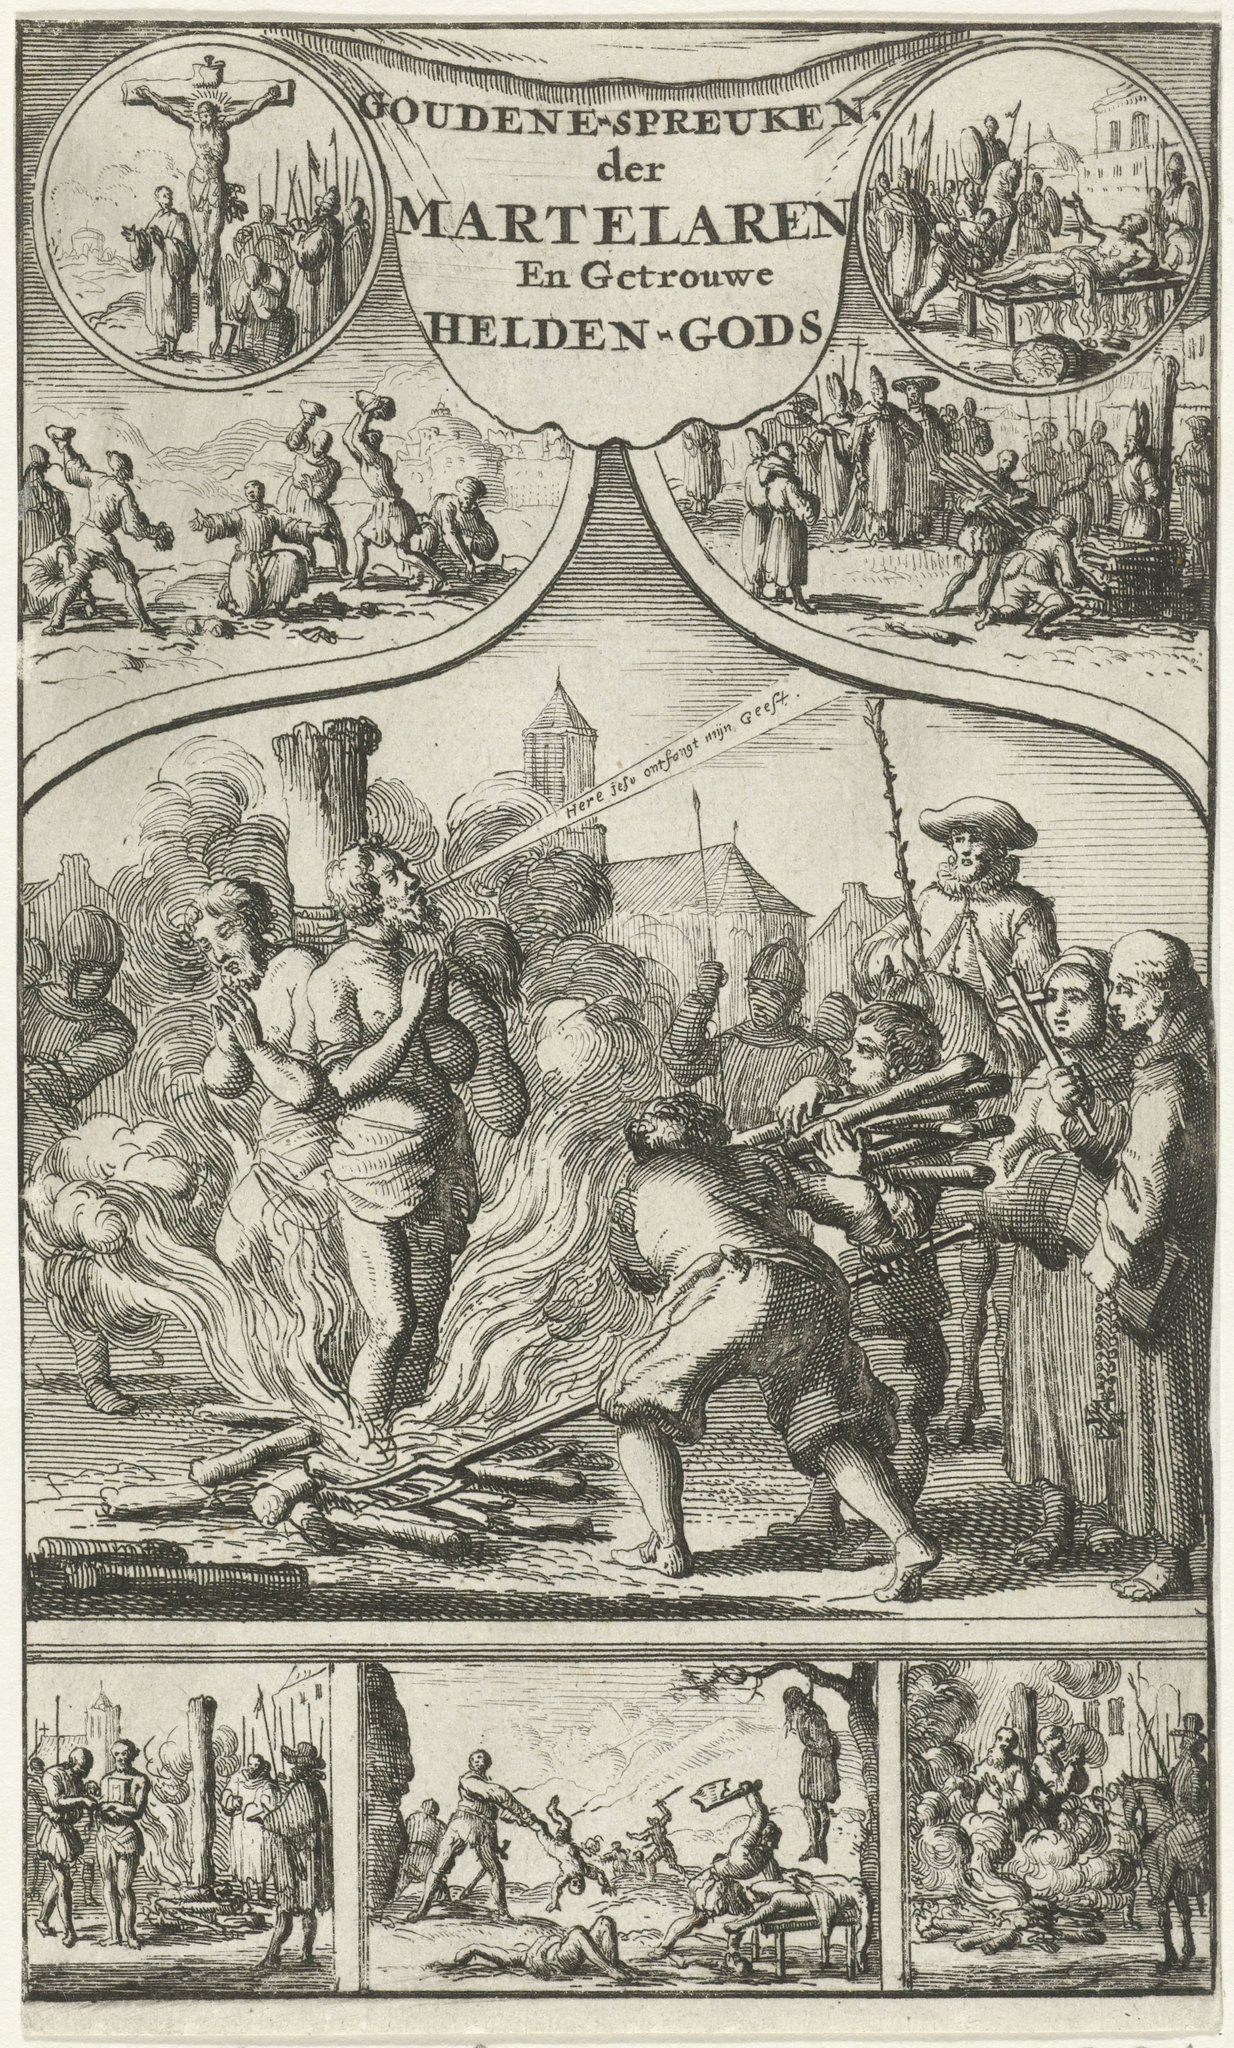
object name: print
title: Twee vastgebonden mannen worden levend verbrand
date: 1683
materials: paper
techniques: etching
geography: amsterdam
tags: christ crucified on a 'living' cross, martyrdom and death of stephen, st. laurence is roasted on a gridiron, violent death ~ fire, violent death, being killed; being mishandled and maltreated; seeking death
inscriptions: collector's mark: Lugt 2228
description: Twee vastgebonden mannen worden levend verbrand. Onder deze hoofdvoorstelling drie scènes waarin figuren op wrede wijze worden vermoord. Boven de hoofdvoorstelling zijn de kruisiging van Christus, de steniging van Stephanus en Laurentius op het rooster afgebeeld.